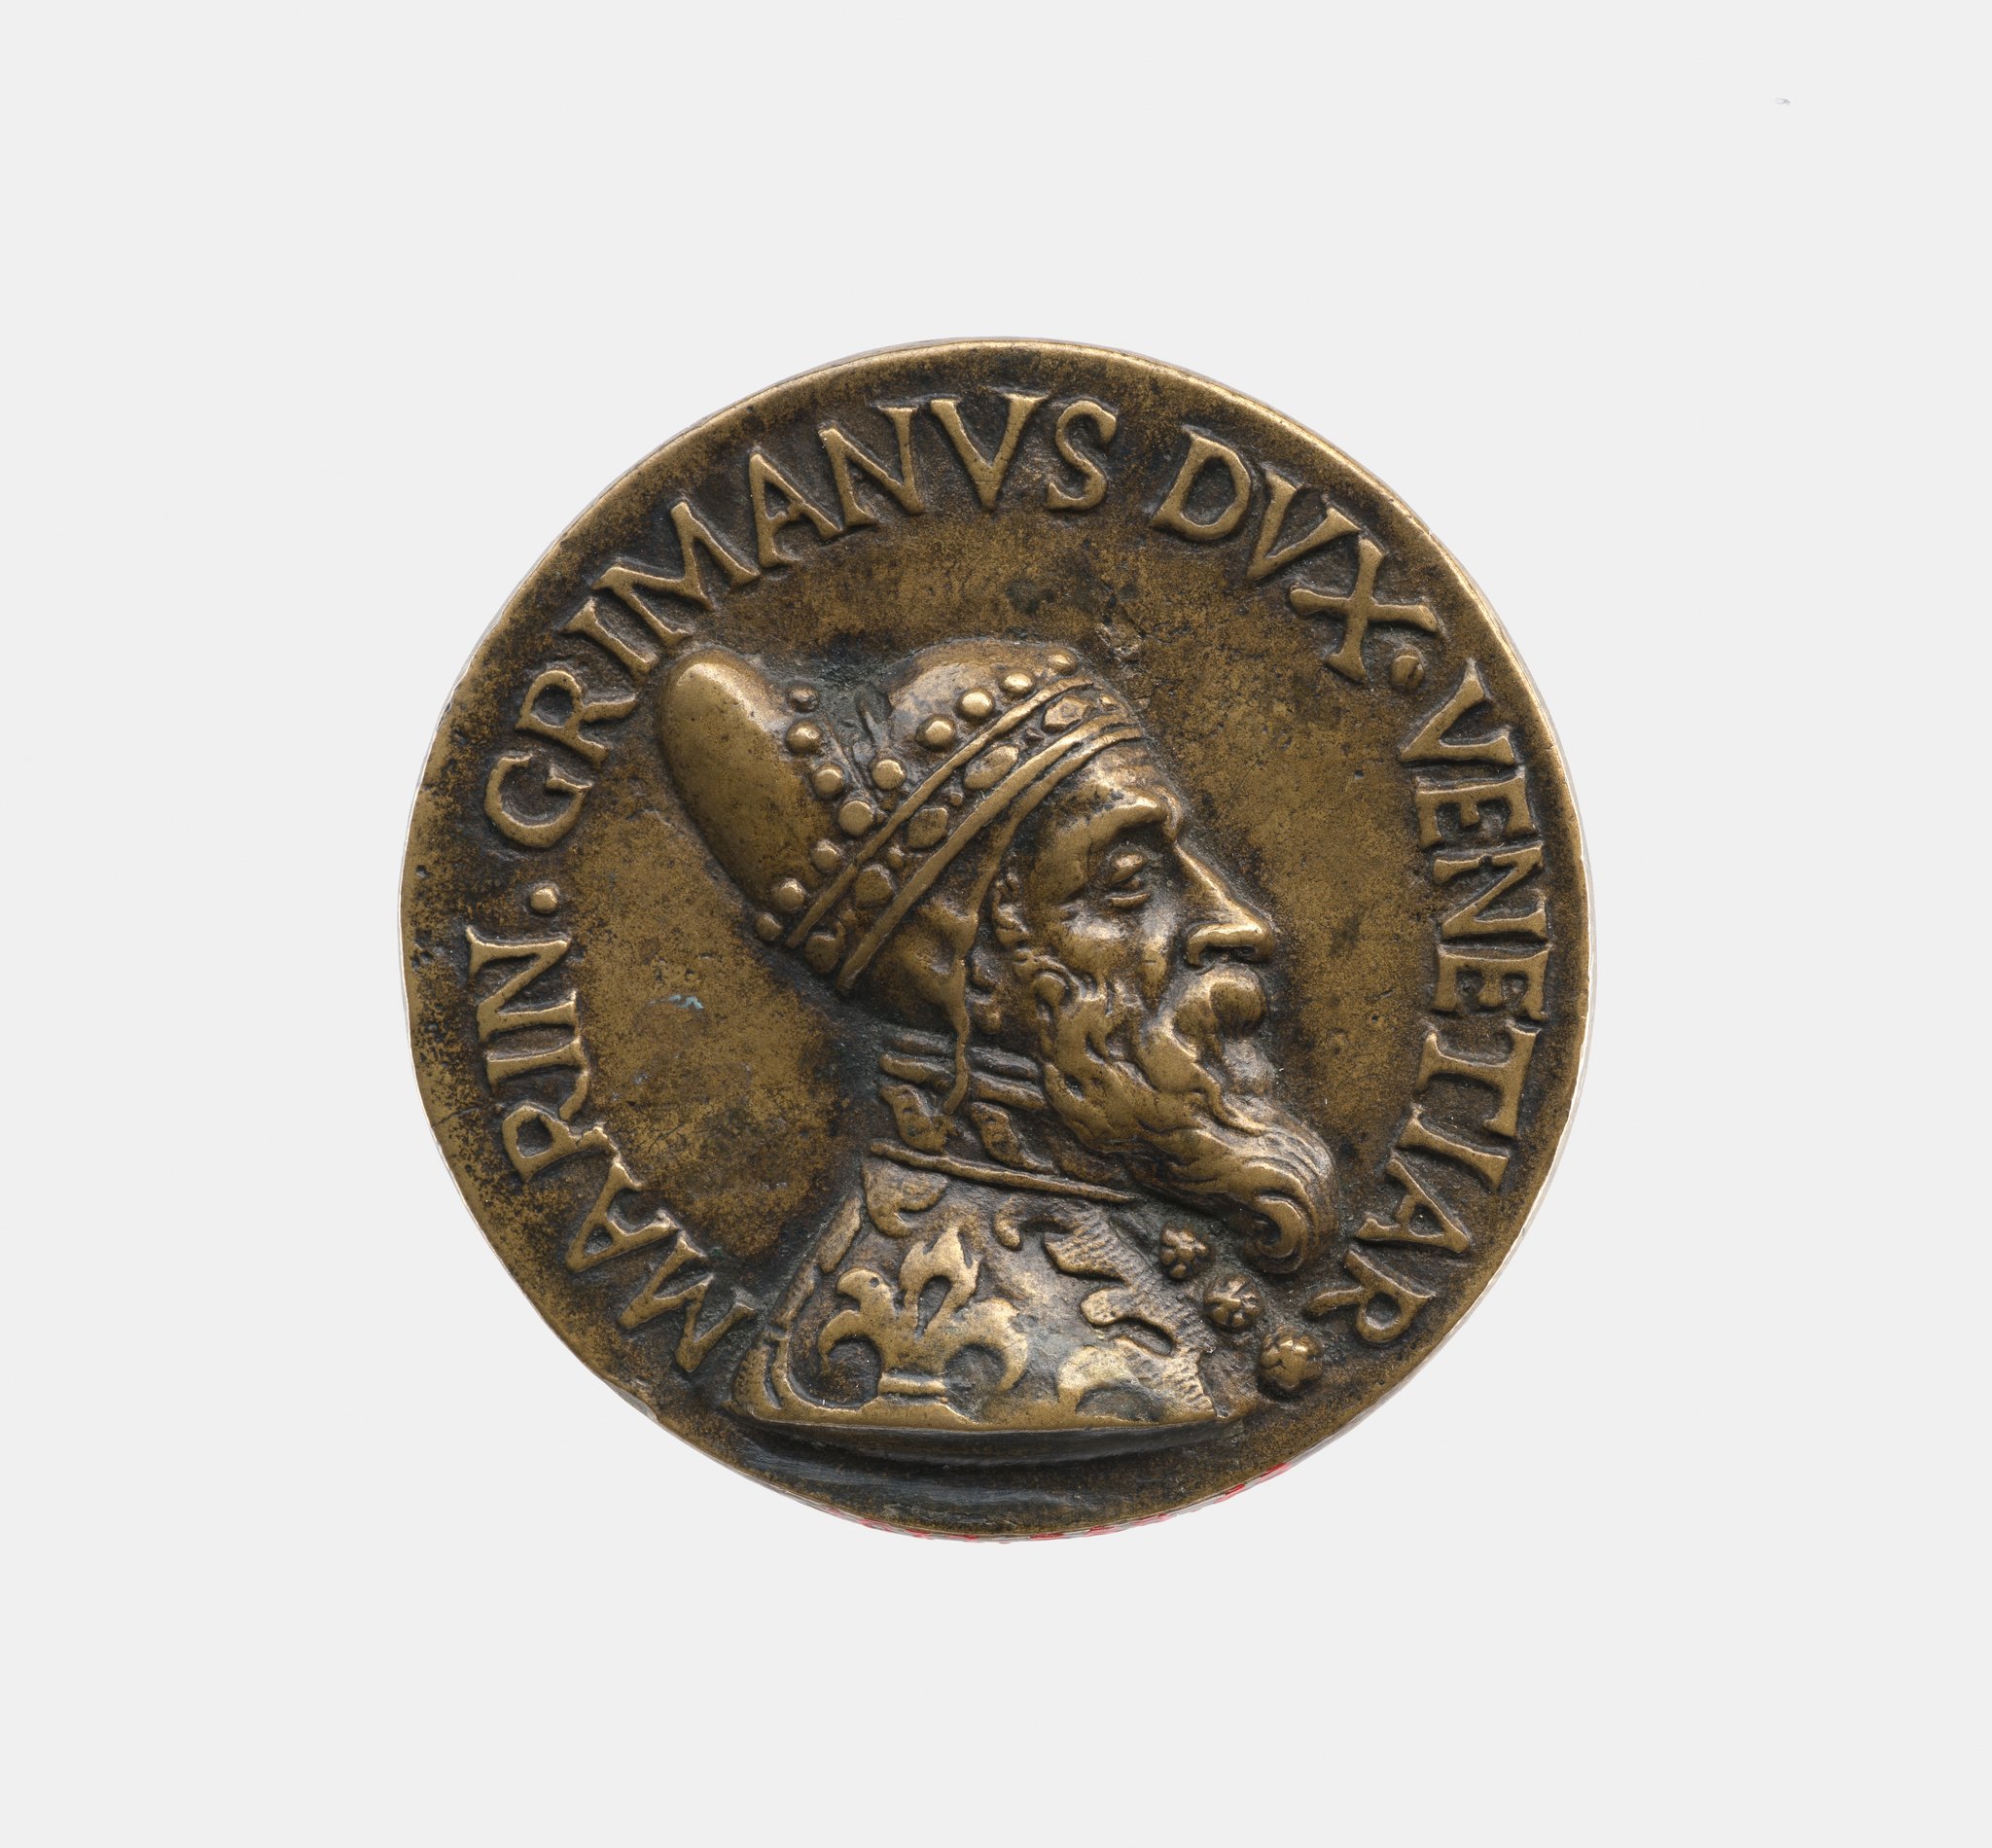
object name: medal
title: Marino Grimani, Doge of Venice 1595-1606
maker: Anonymous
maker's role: artist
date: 1595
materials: bronze